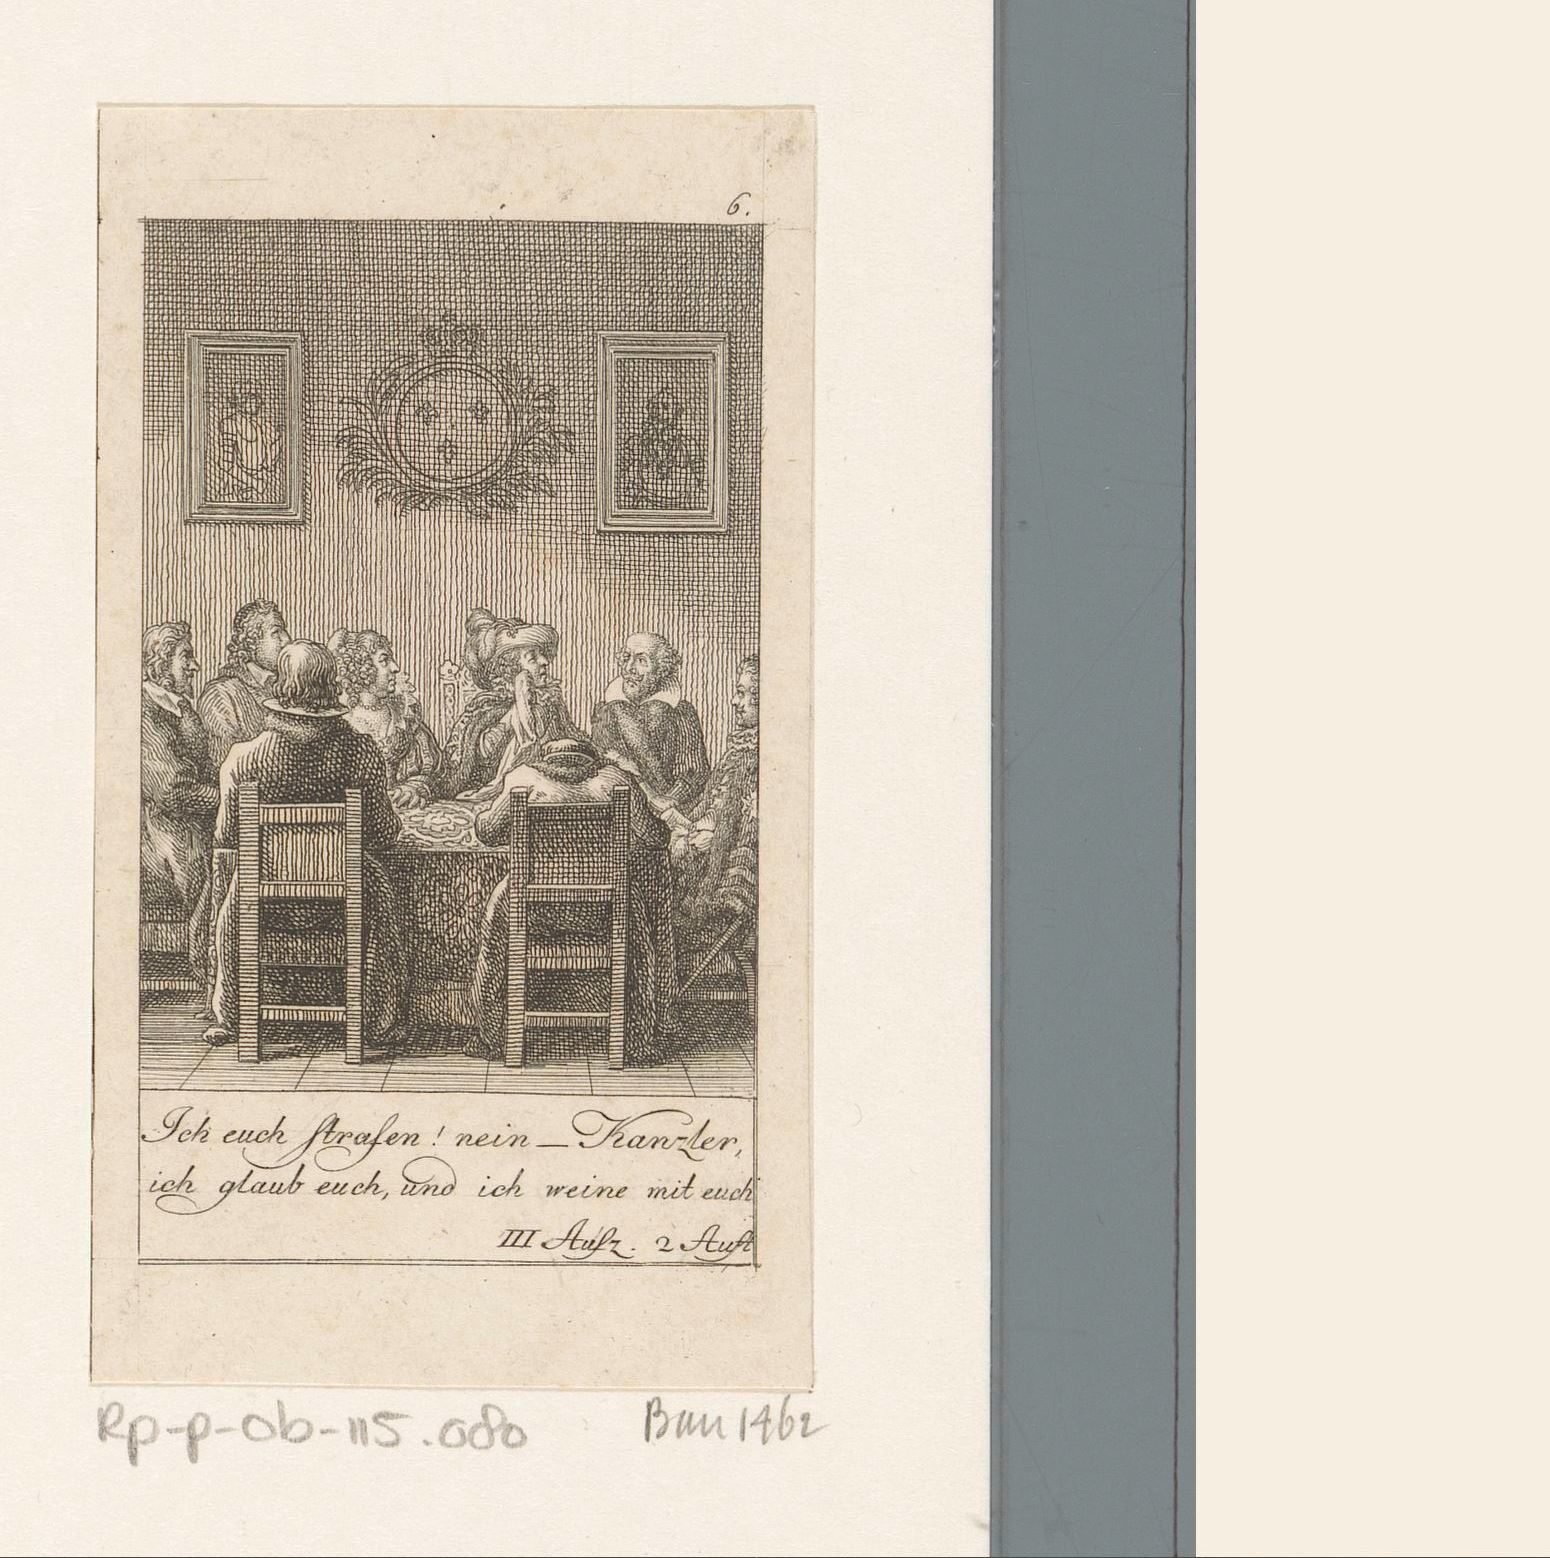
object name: print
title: Vergadering voorafgaand aan Bartholomeusnacht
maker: daniel nikolaus chodowiecki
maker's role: draughtsman, print maker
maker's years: 1726-1801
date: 1790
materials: paper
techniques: etching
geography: berlin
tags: karel ix (koning van frankrijk), meeting, paris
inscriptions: collector's mark: Lugt 2228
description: Vervaardigd voor 'Charles IX' van Marie-Joseph Chénier. Prent gebruikt voor: Goettinger Taschen Calender für 1791. bey Joh. Chr. Dietrich. Göttingen: Johann Christoph Dietrich, [1790].